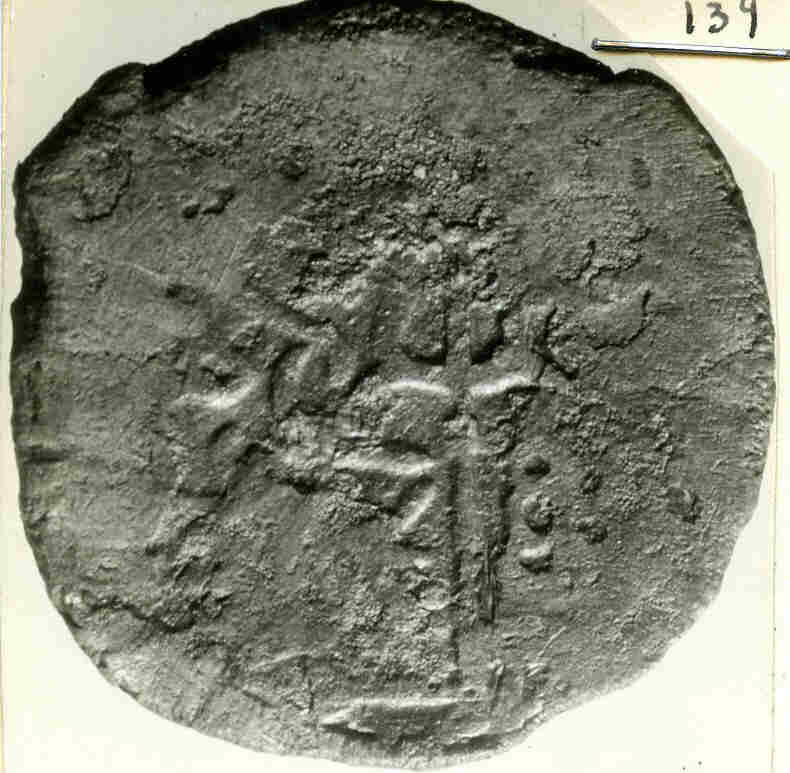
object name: coin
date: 1267-1300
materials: copper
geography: iran